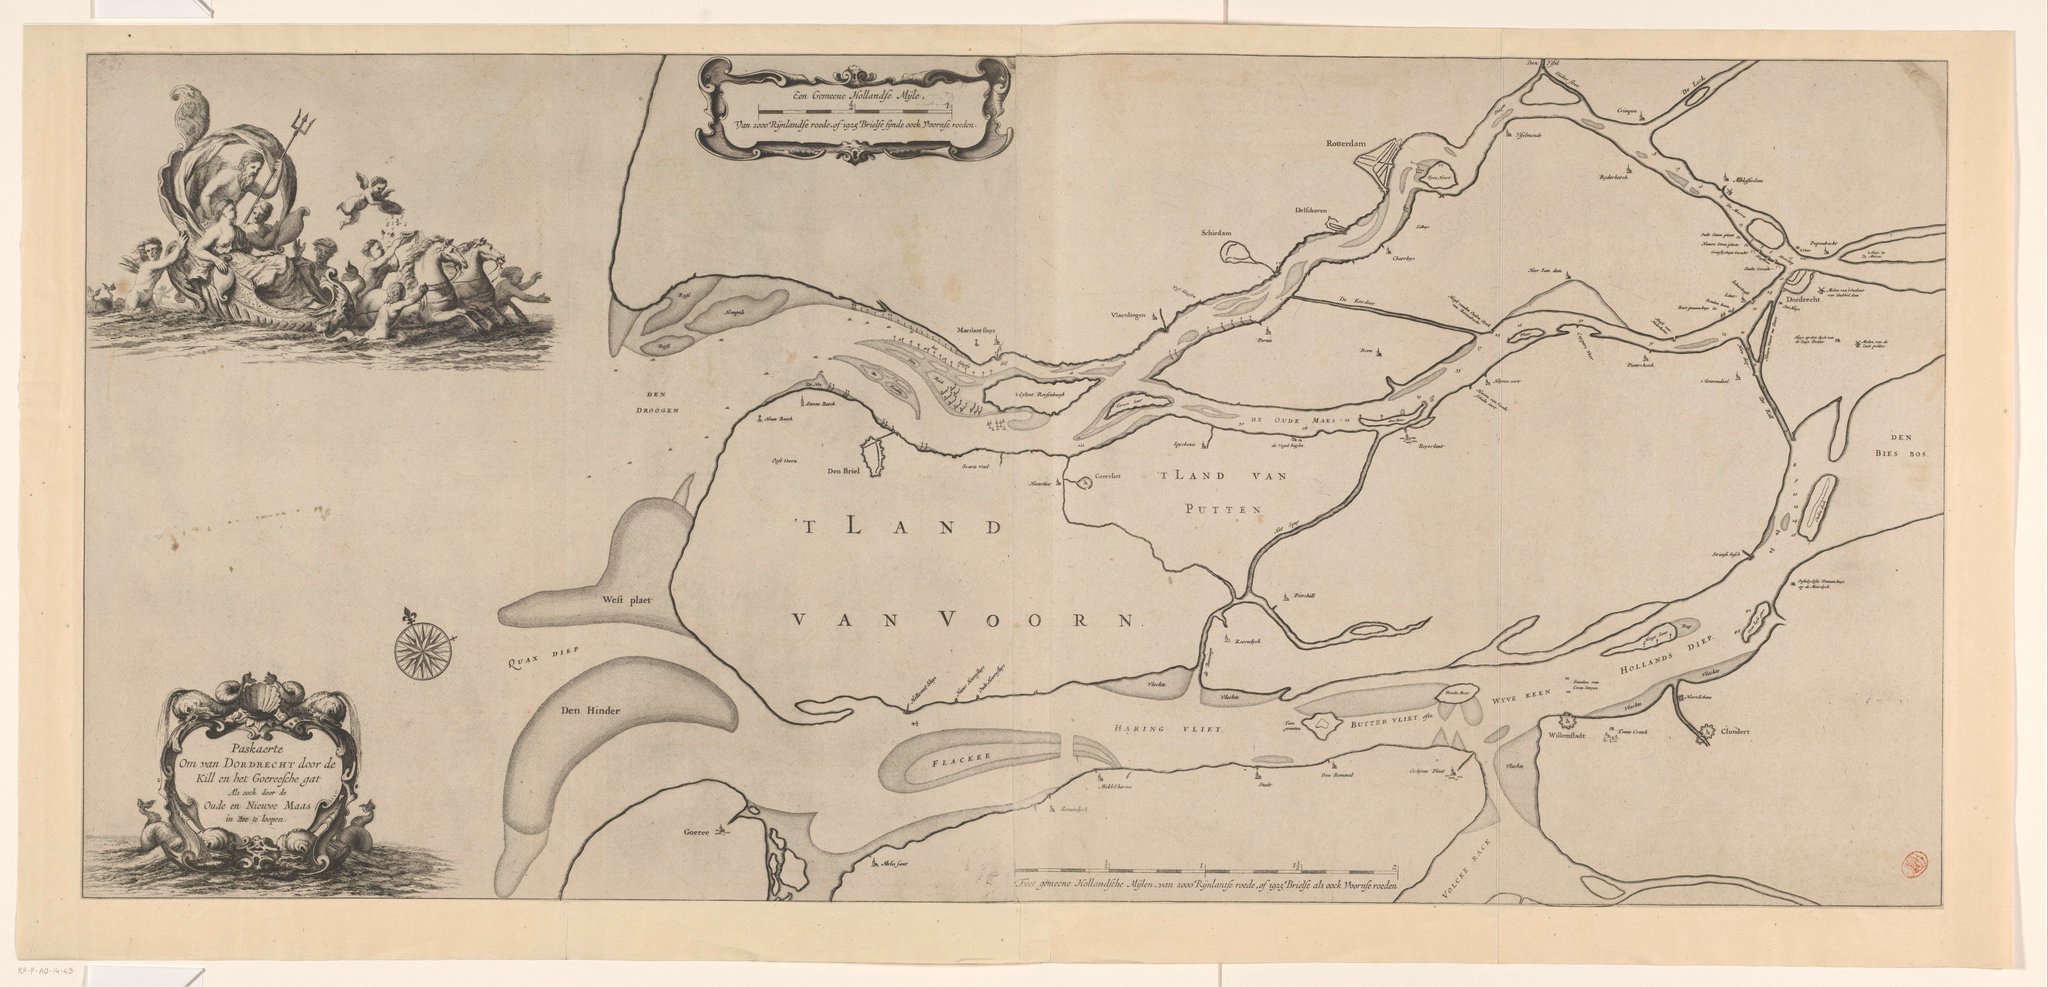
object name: print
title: Paskaerte om van Dordrecht door de kill en het Goereesche gat als oock door de Oude en Nieuwe Maas in zee te loopen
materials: paper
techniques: engraving, etching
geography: amsterdam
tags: (story of) neptune (poseidon), triumph of neptune and amphitrite, with a retinue of tritons and nereids, i.e. marriage train, marine charts, triton(s), maps of separate countries or regions, sea-horse, hippocamp, 'hippocampus', (horse/fish) (mythological hybrid monster), (story of) amphitrite, cupids: 'amores', 'amoretti', 'putti'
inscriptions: collector's mark: Lugt 195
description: Op deze paskaart ontbreken de kompaslijnen omdat het vermoedelijk een proefdruk is. Van beide helften van de kaart is een latere staat bekend. De twee helften konden, zoals hier gedaan is, samengevoegd worden tot een grote kaart of ieder al losse kaart gebruikt worden. De latere staat van de linkerhelft draagt de titel 'Paskaerte van het inkoomen van de Maes tot aen 't eylandt Roosenburgh als mede 't inkoomen van 't Goereesche gat, tot aen Oude Hoornsluys, met hunne droogte en diepte. Seer naeukeurich opgestelt'. De latere staat van de rechterhelft draagt de titel 'Pascaert van 't eylandt Roosenburg door de Oude en Nieuwe Maes tot aen Dordrecht en van daer door de Kill tot aen Oudehoornsluys: met hunne diepten en drooghten seer naeuwkeurigh opgestelt'. Deze kaarten komen beiden voor het eerst voor in een zeeatlas van Johannes (I) van Keulen uit 1680.